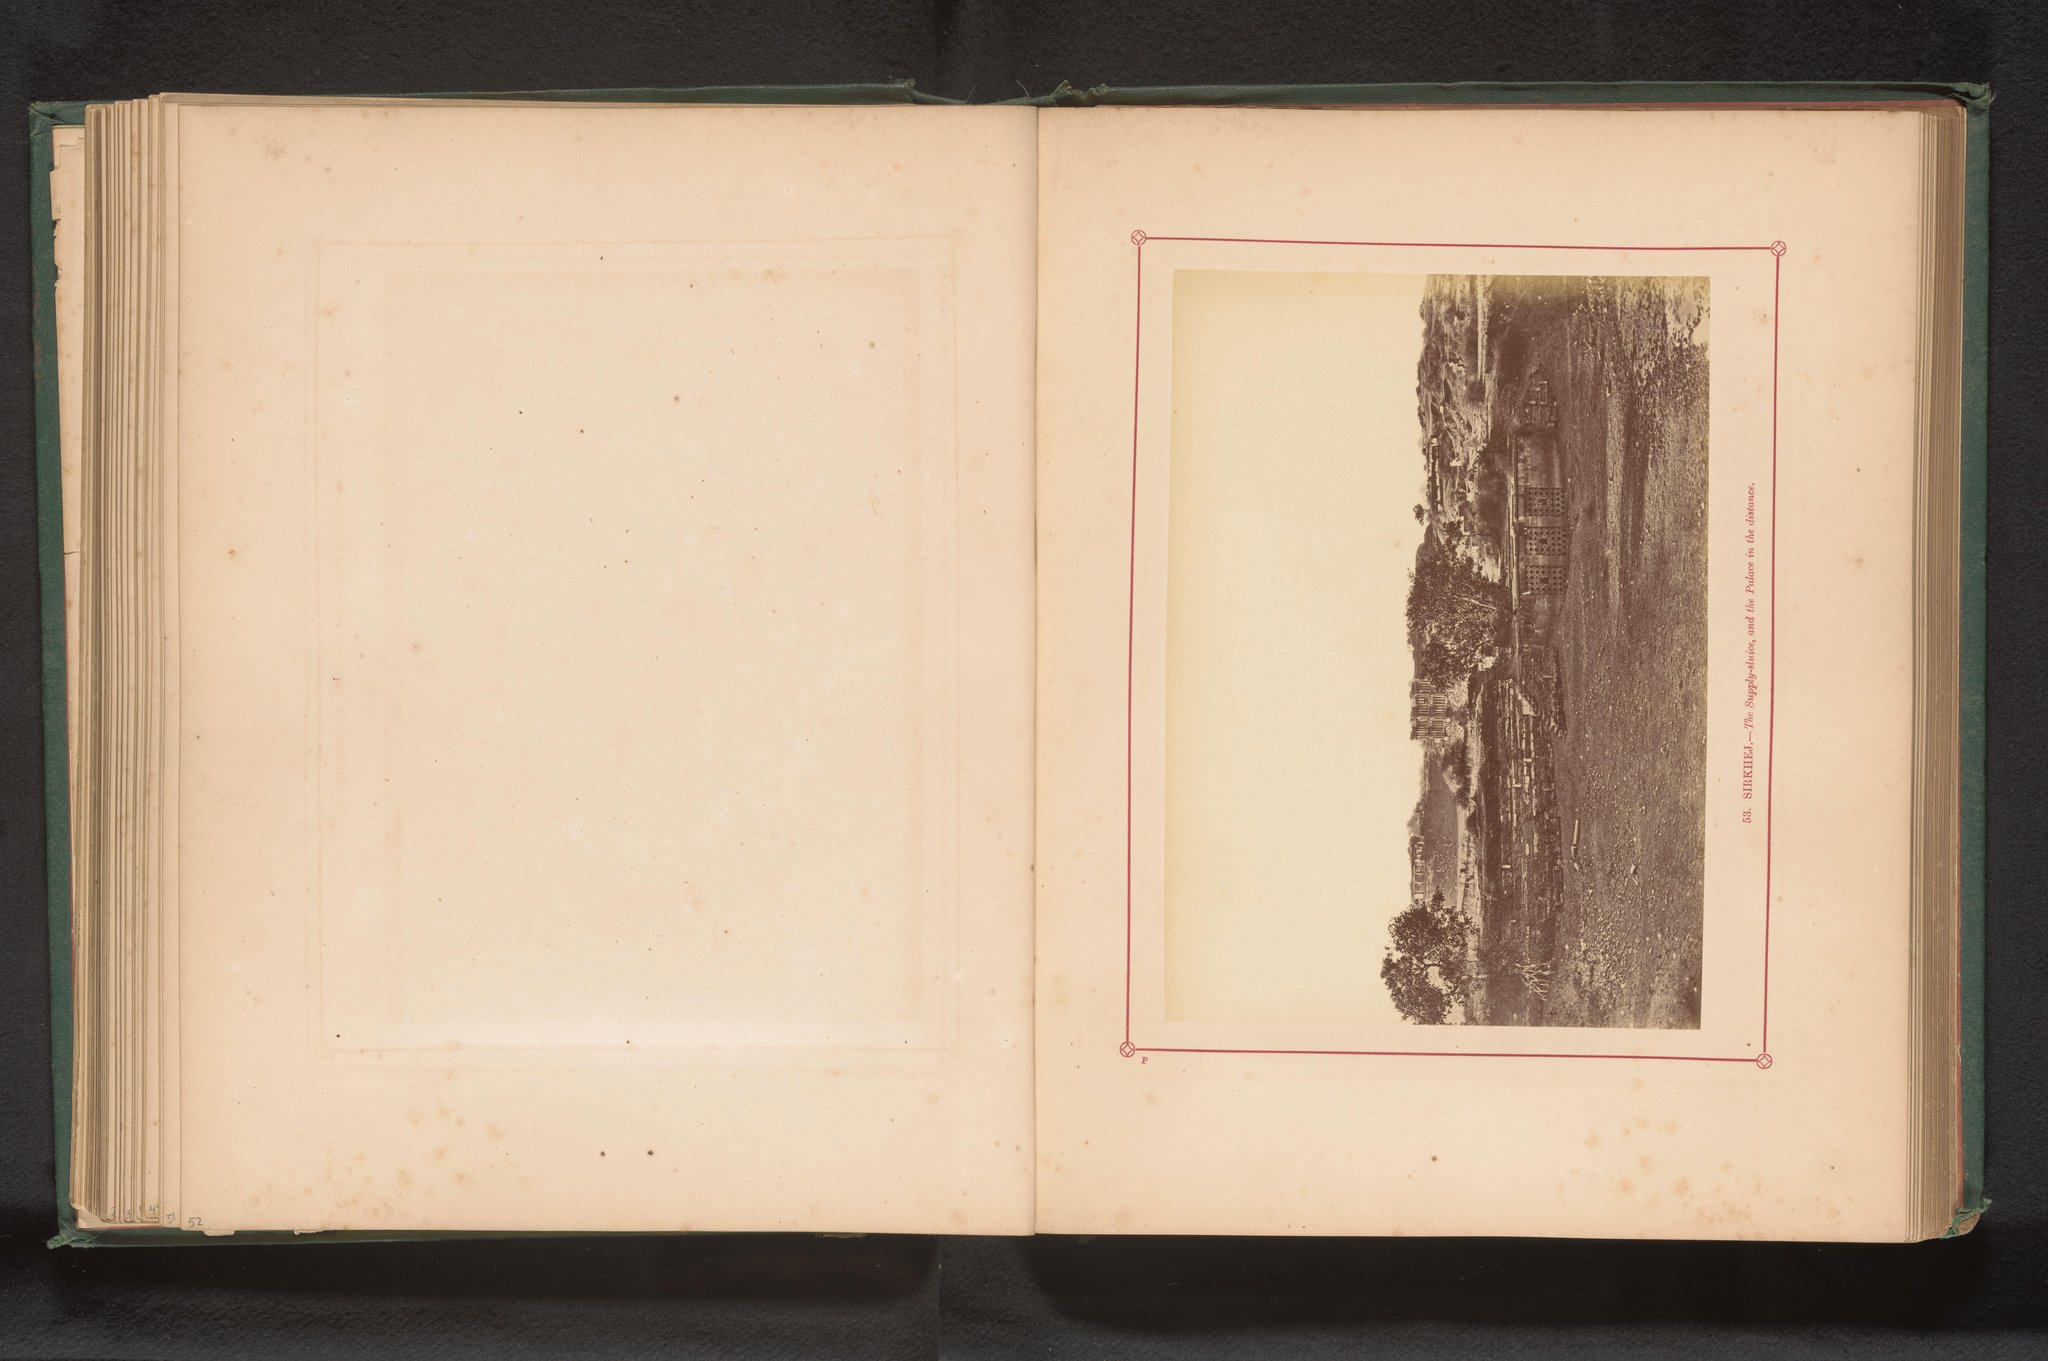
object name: photograph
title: Sirkhej.- The Supply-sluice, and the Palace in the distance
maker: thomas biggs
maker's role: fotograaf, kapitein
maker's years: 1822-1905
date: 1856-1866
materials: photographic support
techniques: albumen print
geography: sarkhej roza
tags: sluice, weir, ruin of a dwelling, house, castle, etc.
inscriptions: number: ‘53.’, inscription: ‘P’